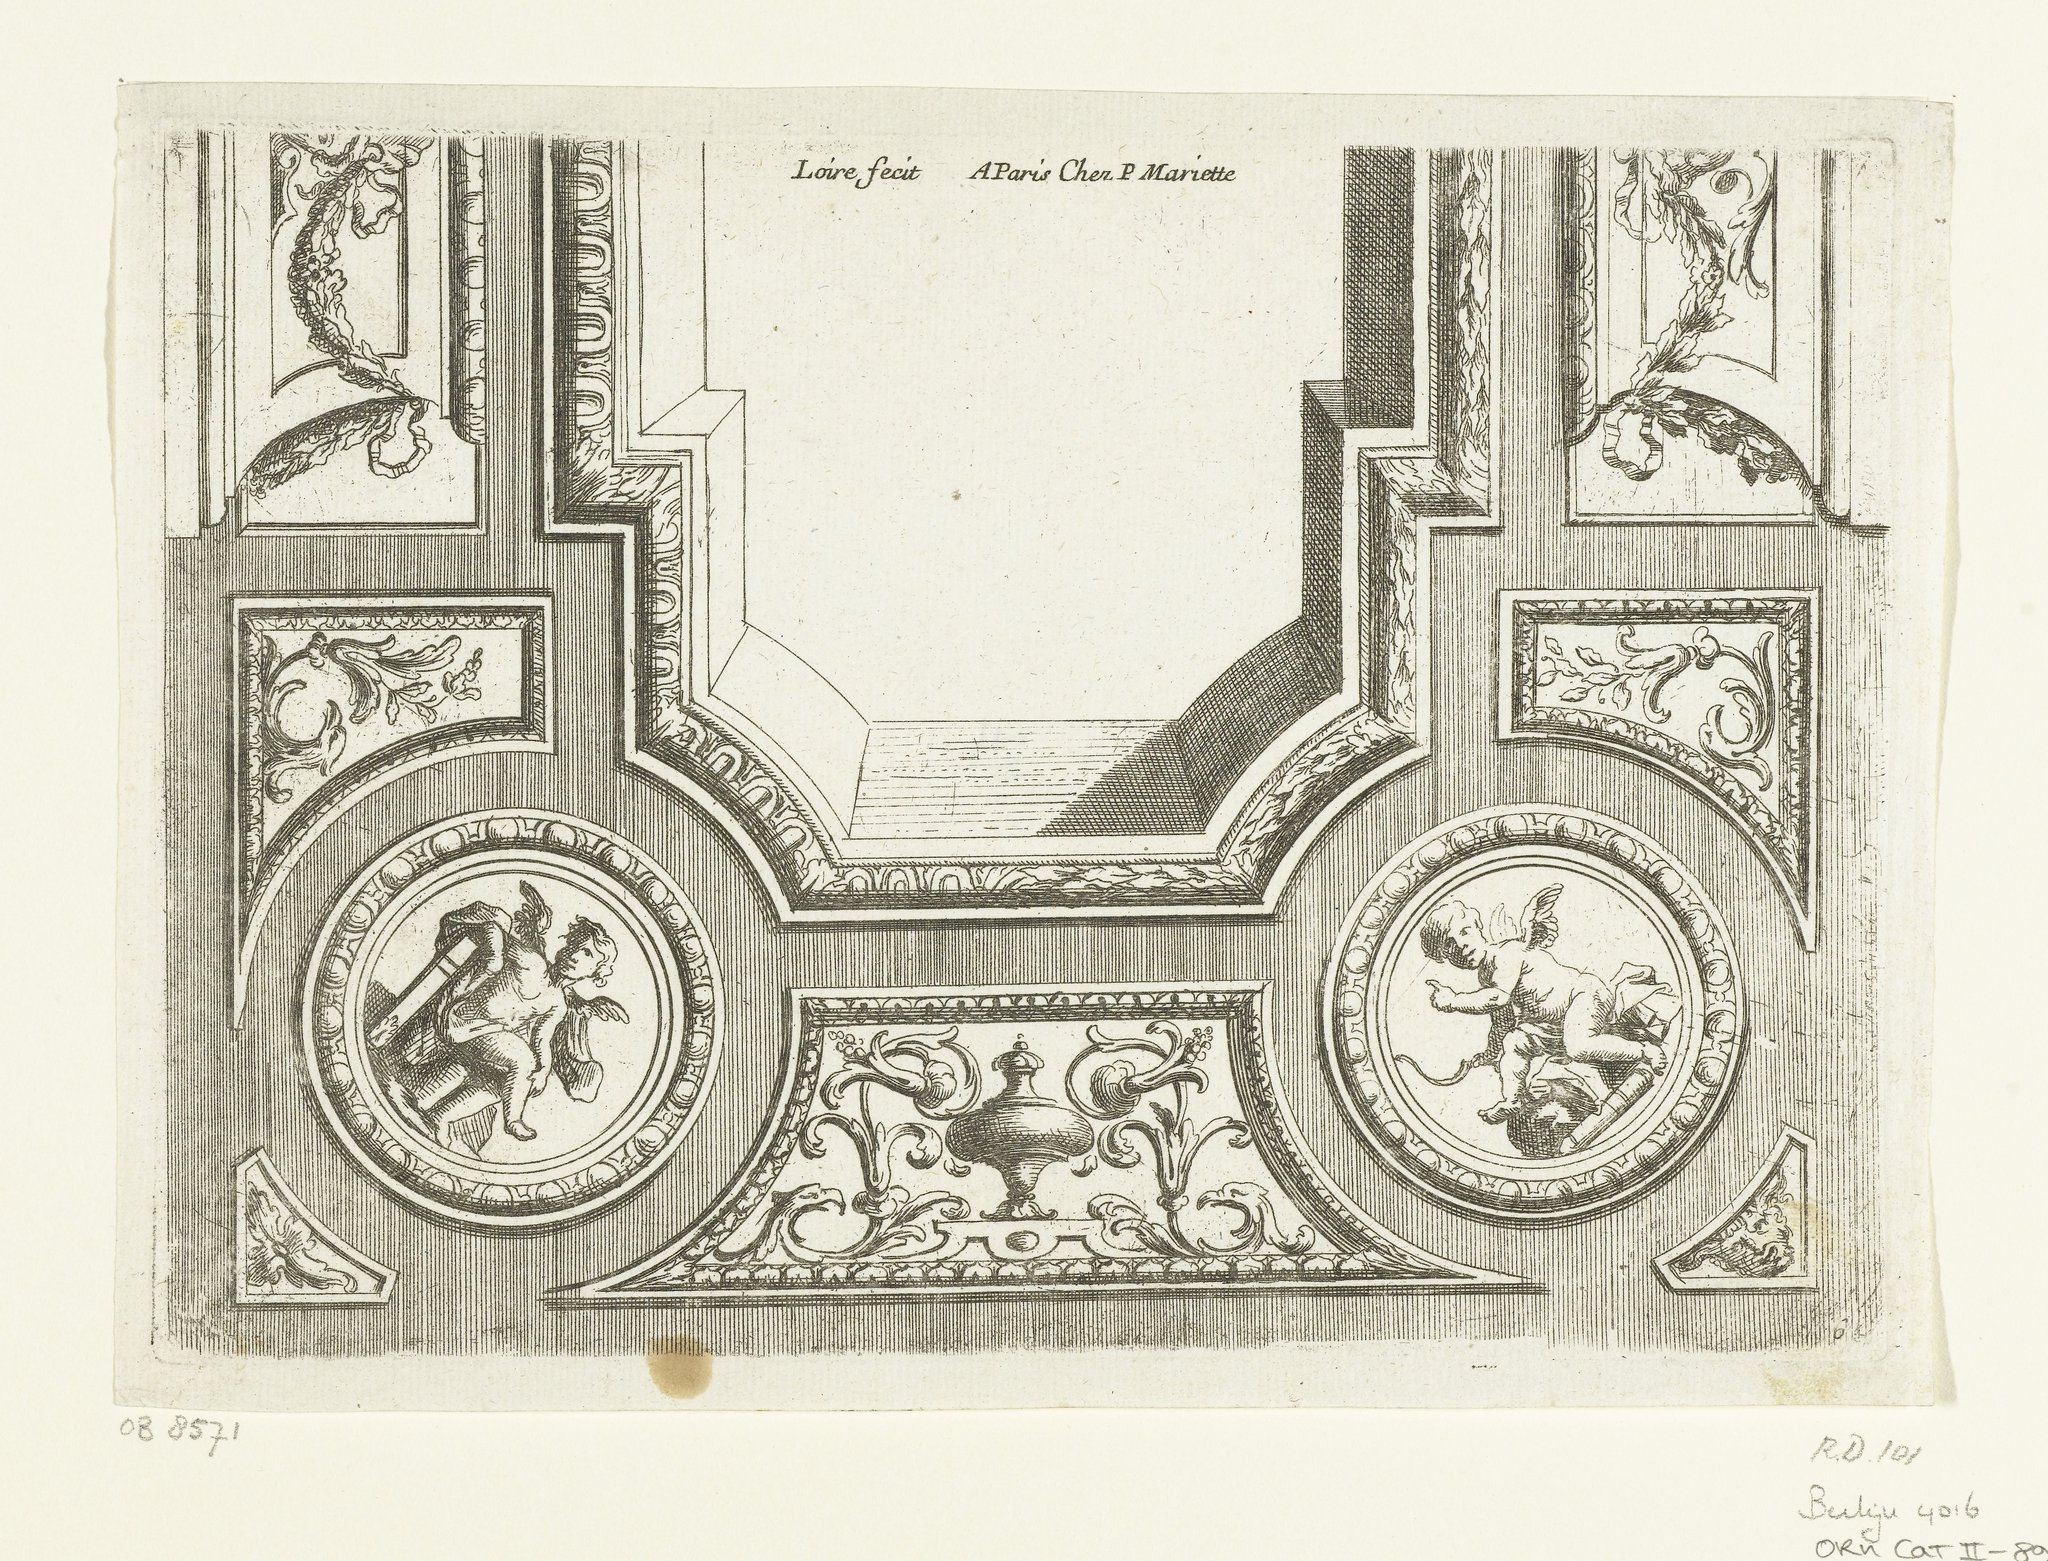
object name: ornament print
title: Plafonds à la moderne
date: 1634-1716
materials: paper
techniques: etching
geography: france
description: Met leeg vlak in het midden en in de hoeken een rond medaillon met Cupido. Uit tweede editie.